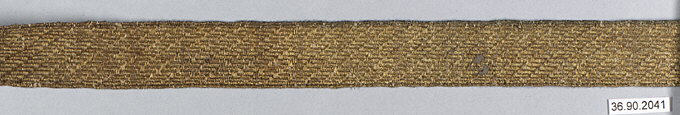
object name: galloon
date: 1801-1900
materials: metal thread, silk